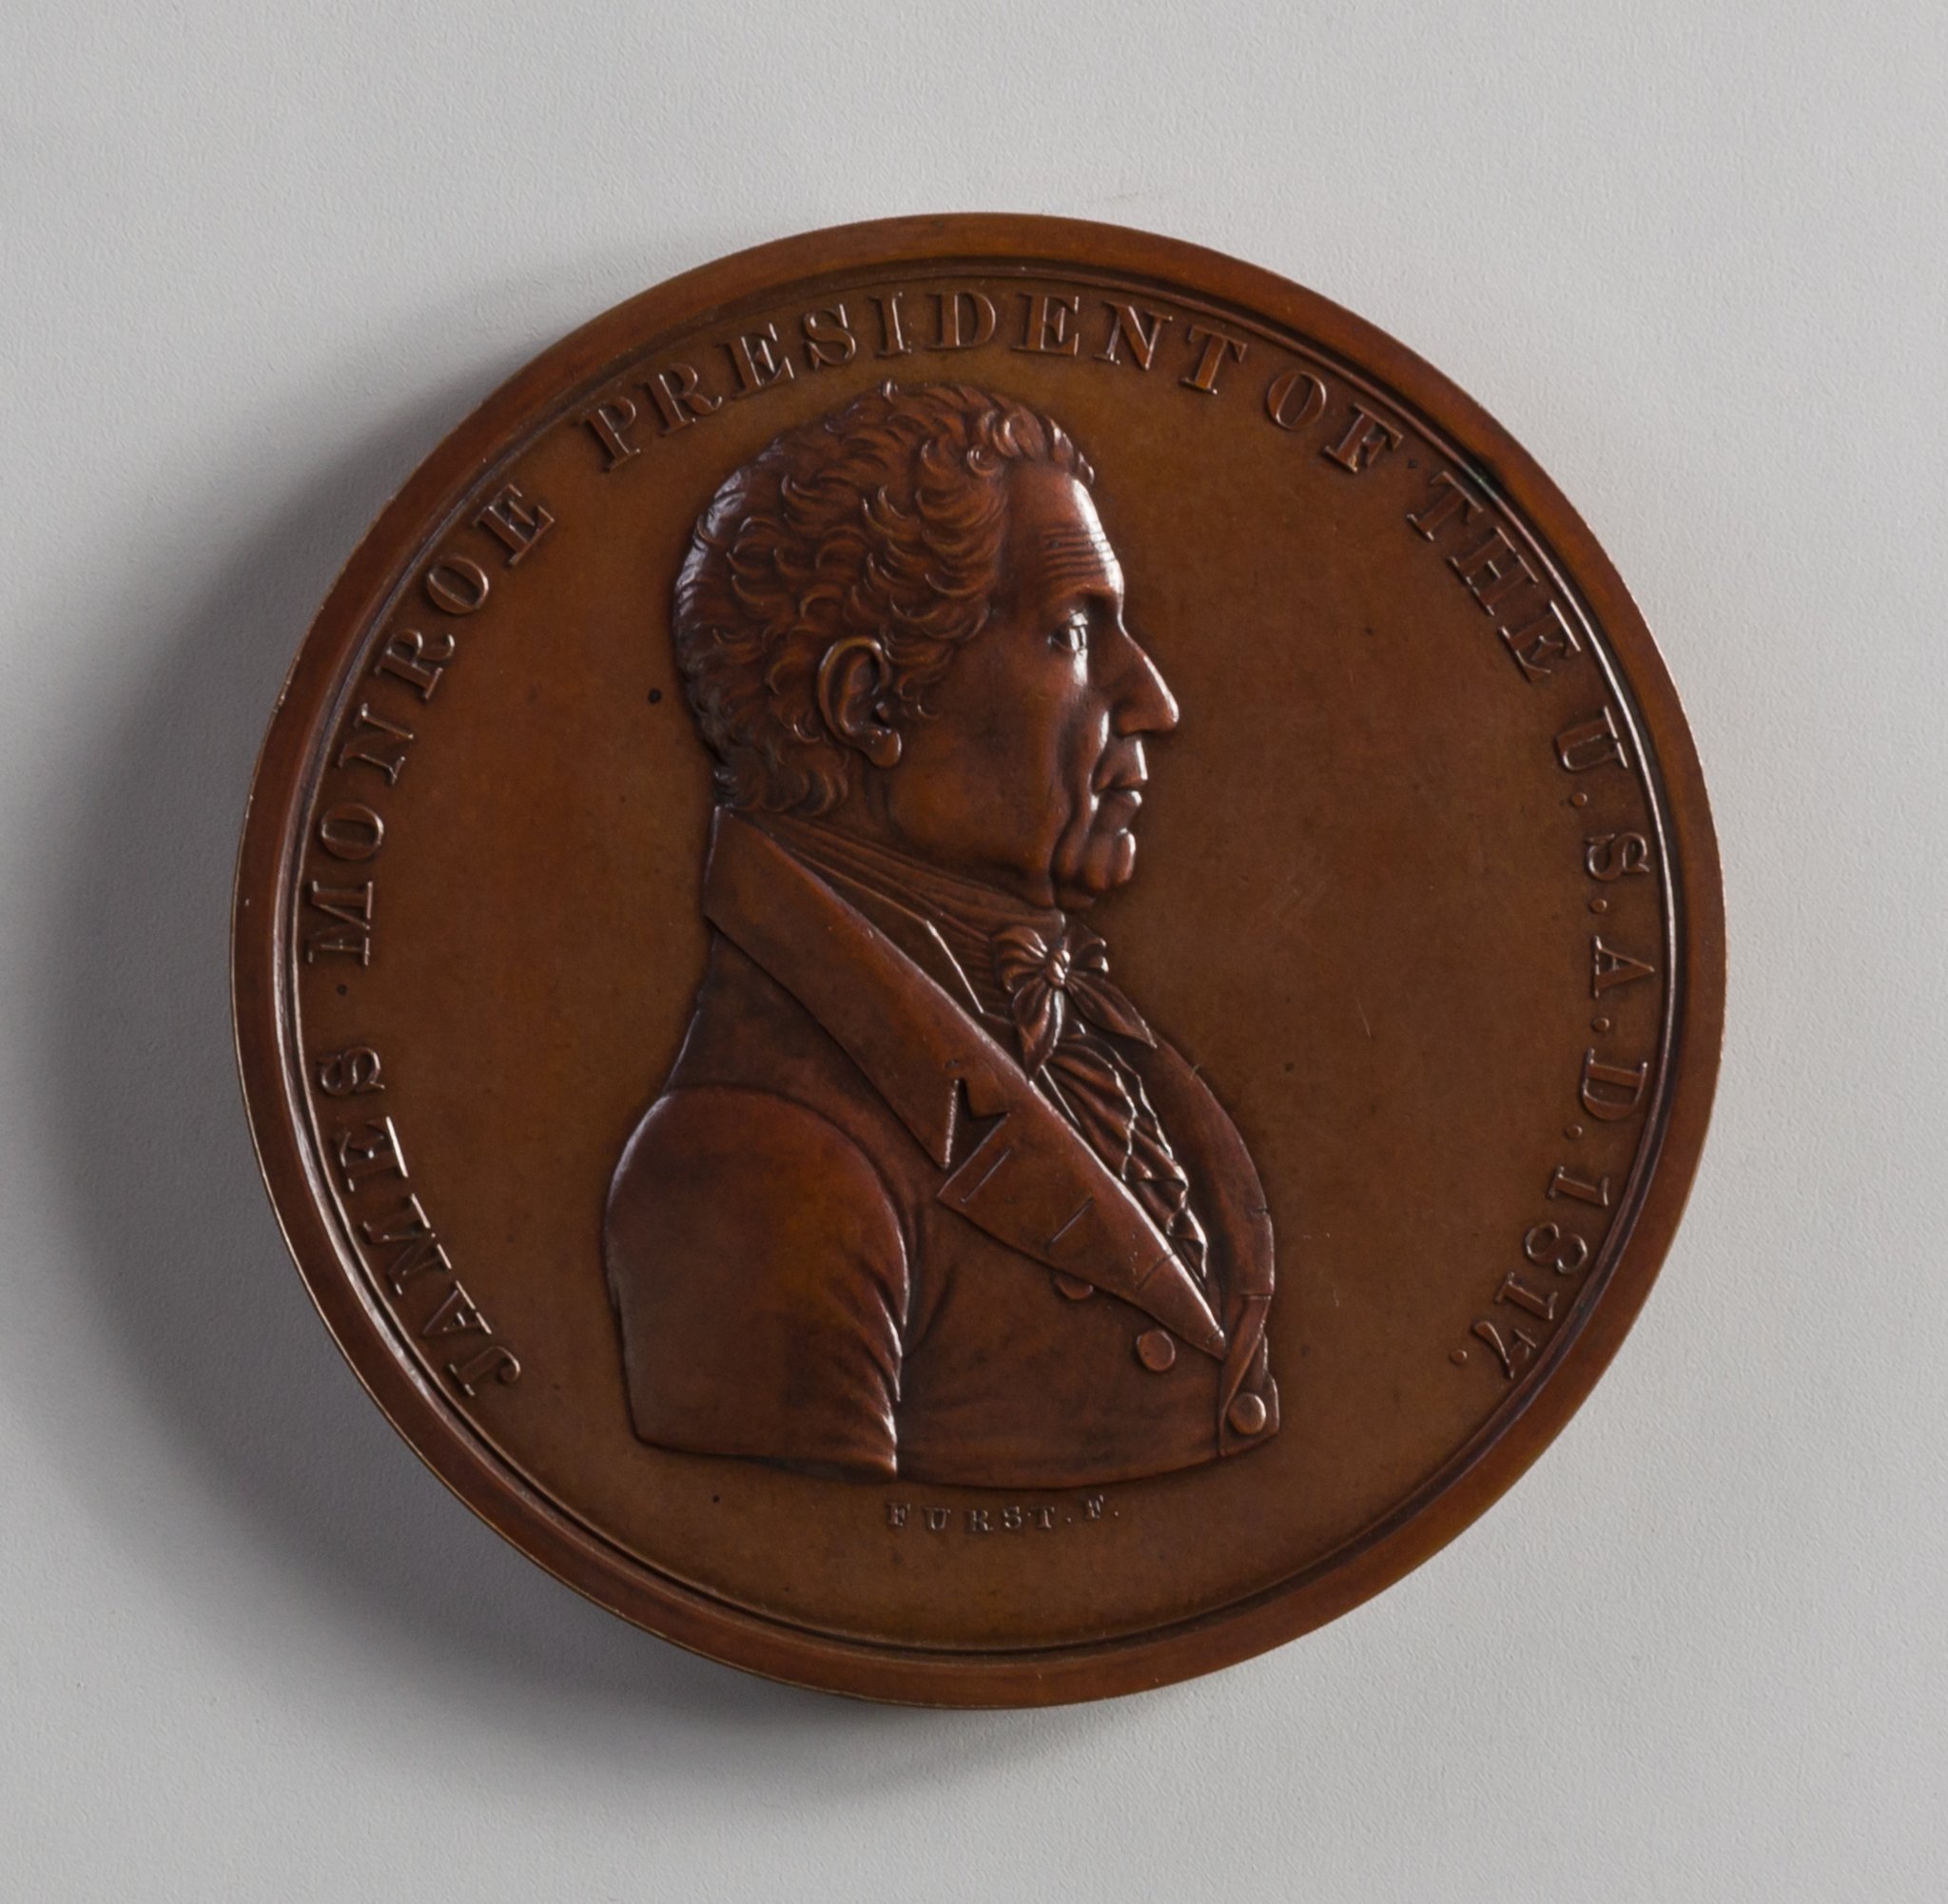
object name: medal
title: Medal of James Monroe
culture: american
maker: moritz fürst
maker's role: maker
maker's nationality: hungarian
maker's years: 1782-1882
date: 1817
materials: bronze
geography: united states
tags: men,profiles